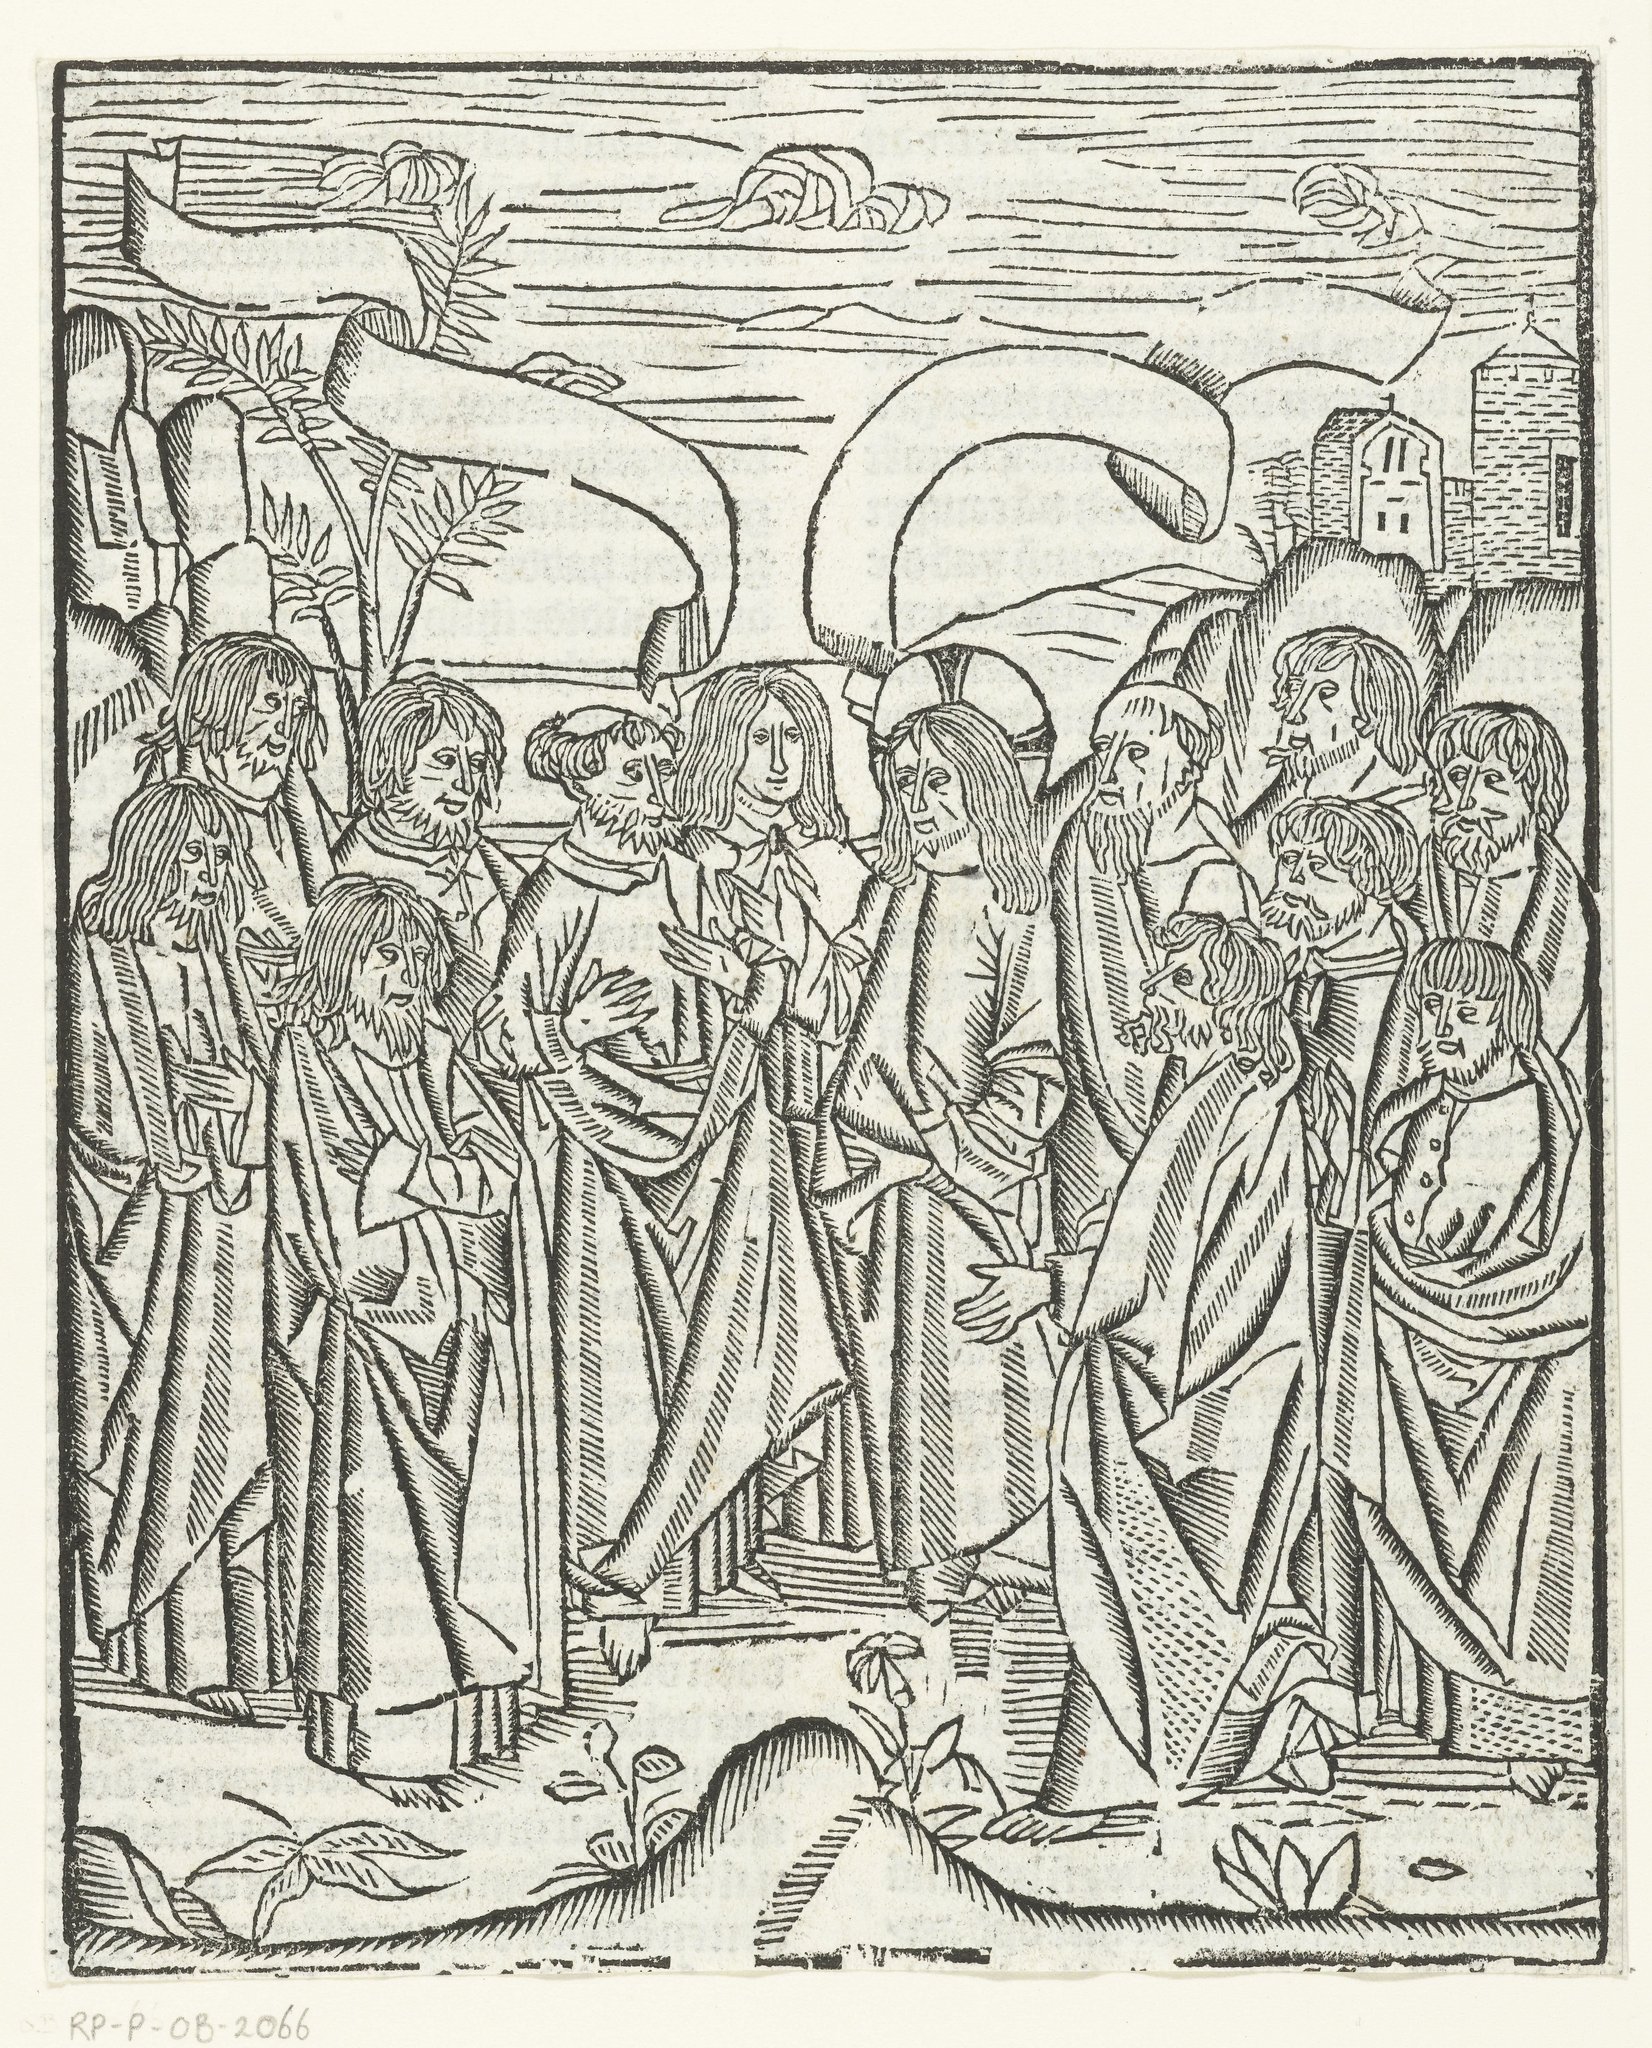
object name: book illustration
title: De belijdenis van Petrus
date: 1480-1500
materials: paper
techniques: woodcut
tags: peter confesses jesus to be the christ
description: Eén blad van 113 uit Ludolphus de Saxonia, "Dit es dleué ons liefs heeren ihesu christi". Anonieme Nederlandse vertaling. Uitgegeven door Henrick Eckert van Homberch te Antwerpen in 1503. Botke, K. Deze 113 houtsneden, die meestal reeds in vroege Nederlandse boeken gebruikt zijn, worden toegeschreven aan de tweede Meester van Delft, de Meester van de Delbecq-Schreiber-passie en de Meester van de Virgo inter Virgines. In Conway (1884) en in "De gulden passer"(1951) zijn ook eerdere versies opgenomen. Botke, K.